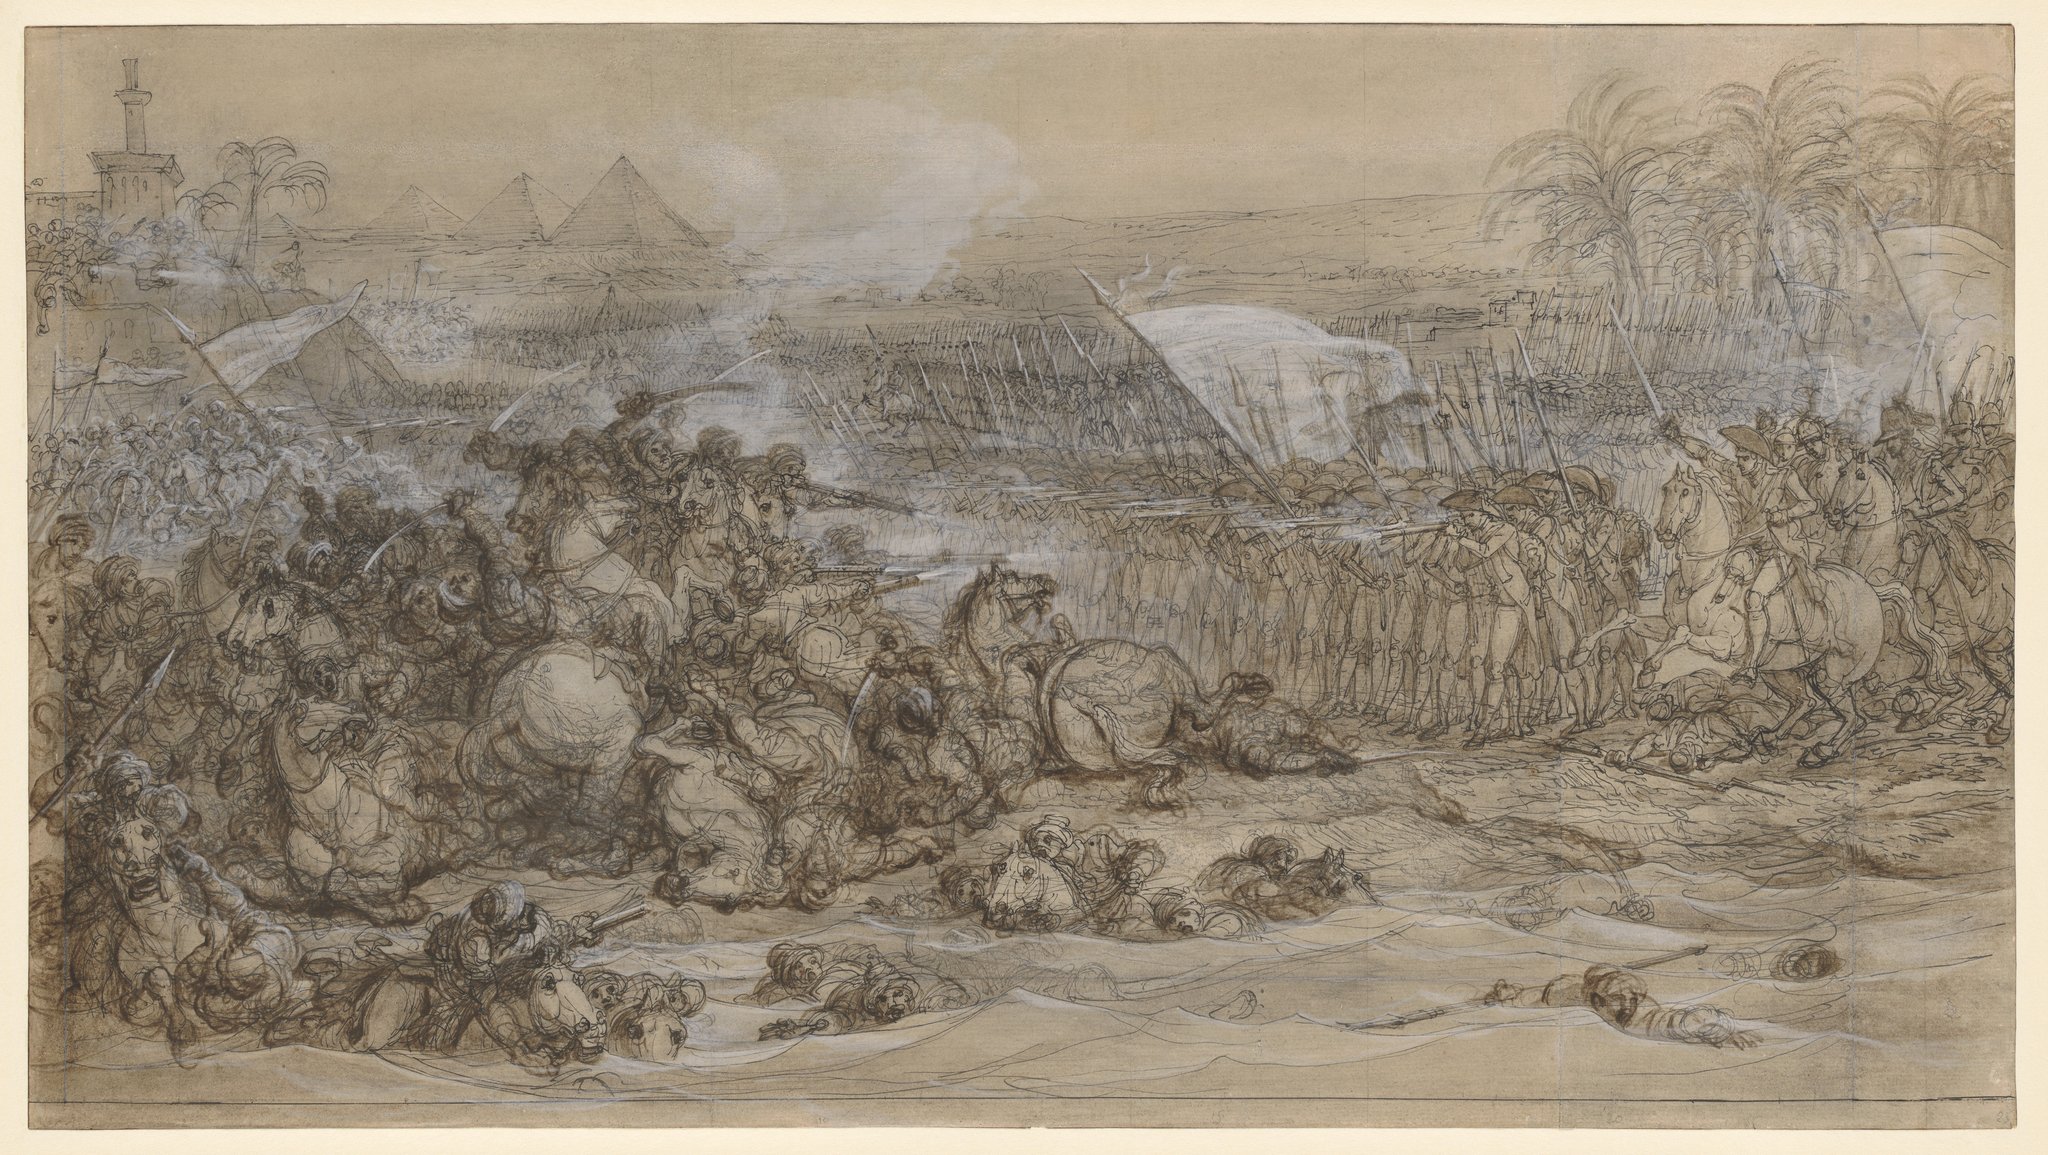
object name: drawing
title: Battle of the Pyramids, July 21, 1798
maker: françois andré vincent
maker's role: artist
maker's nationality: french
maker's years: 1746-1816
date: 1800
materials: graphite, ink, paper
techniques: brush, heightening, pen, drawing, wash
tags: battles,soldiers,horses